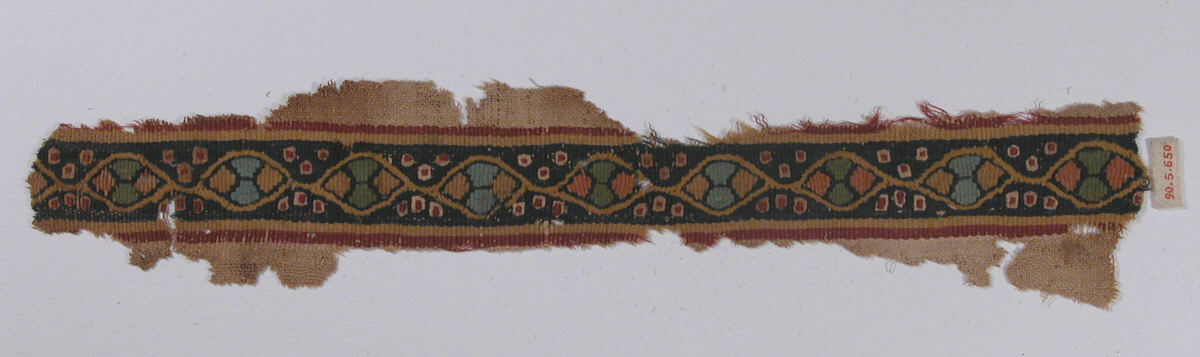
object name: textile fragment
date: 401-600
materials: linen, wool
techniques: weave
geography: egypt